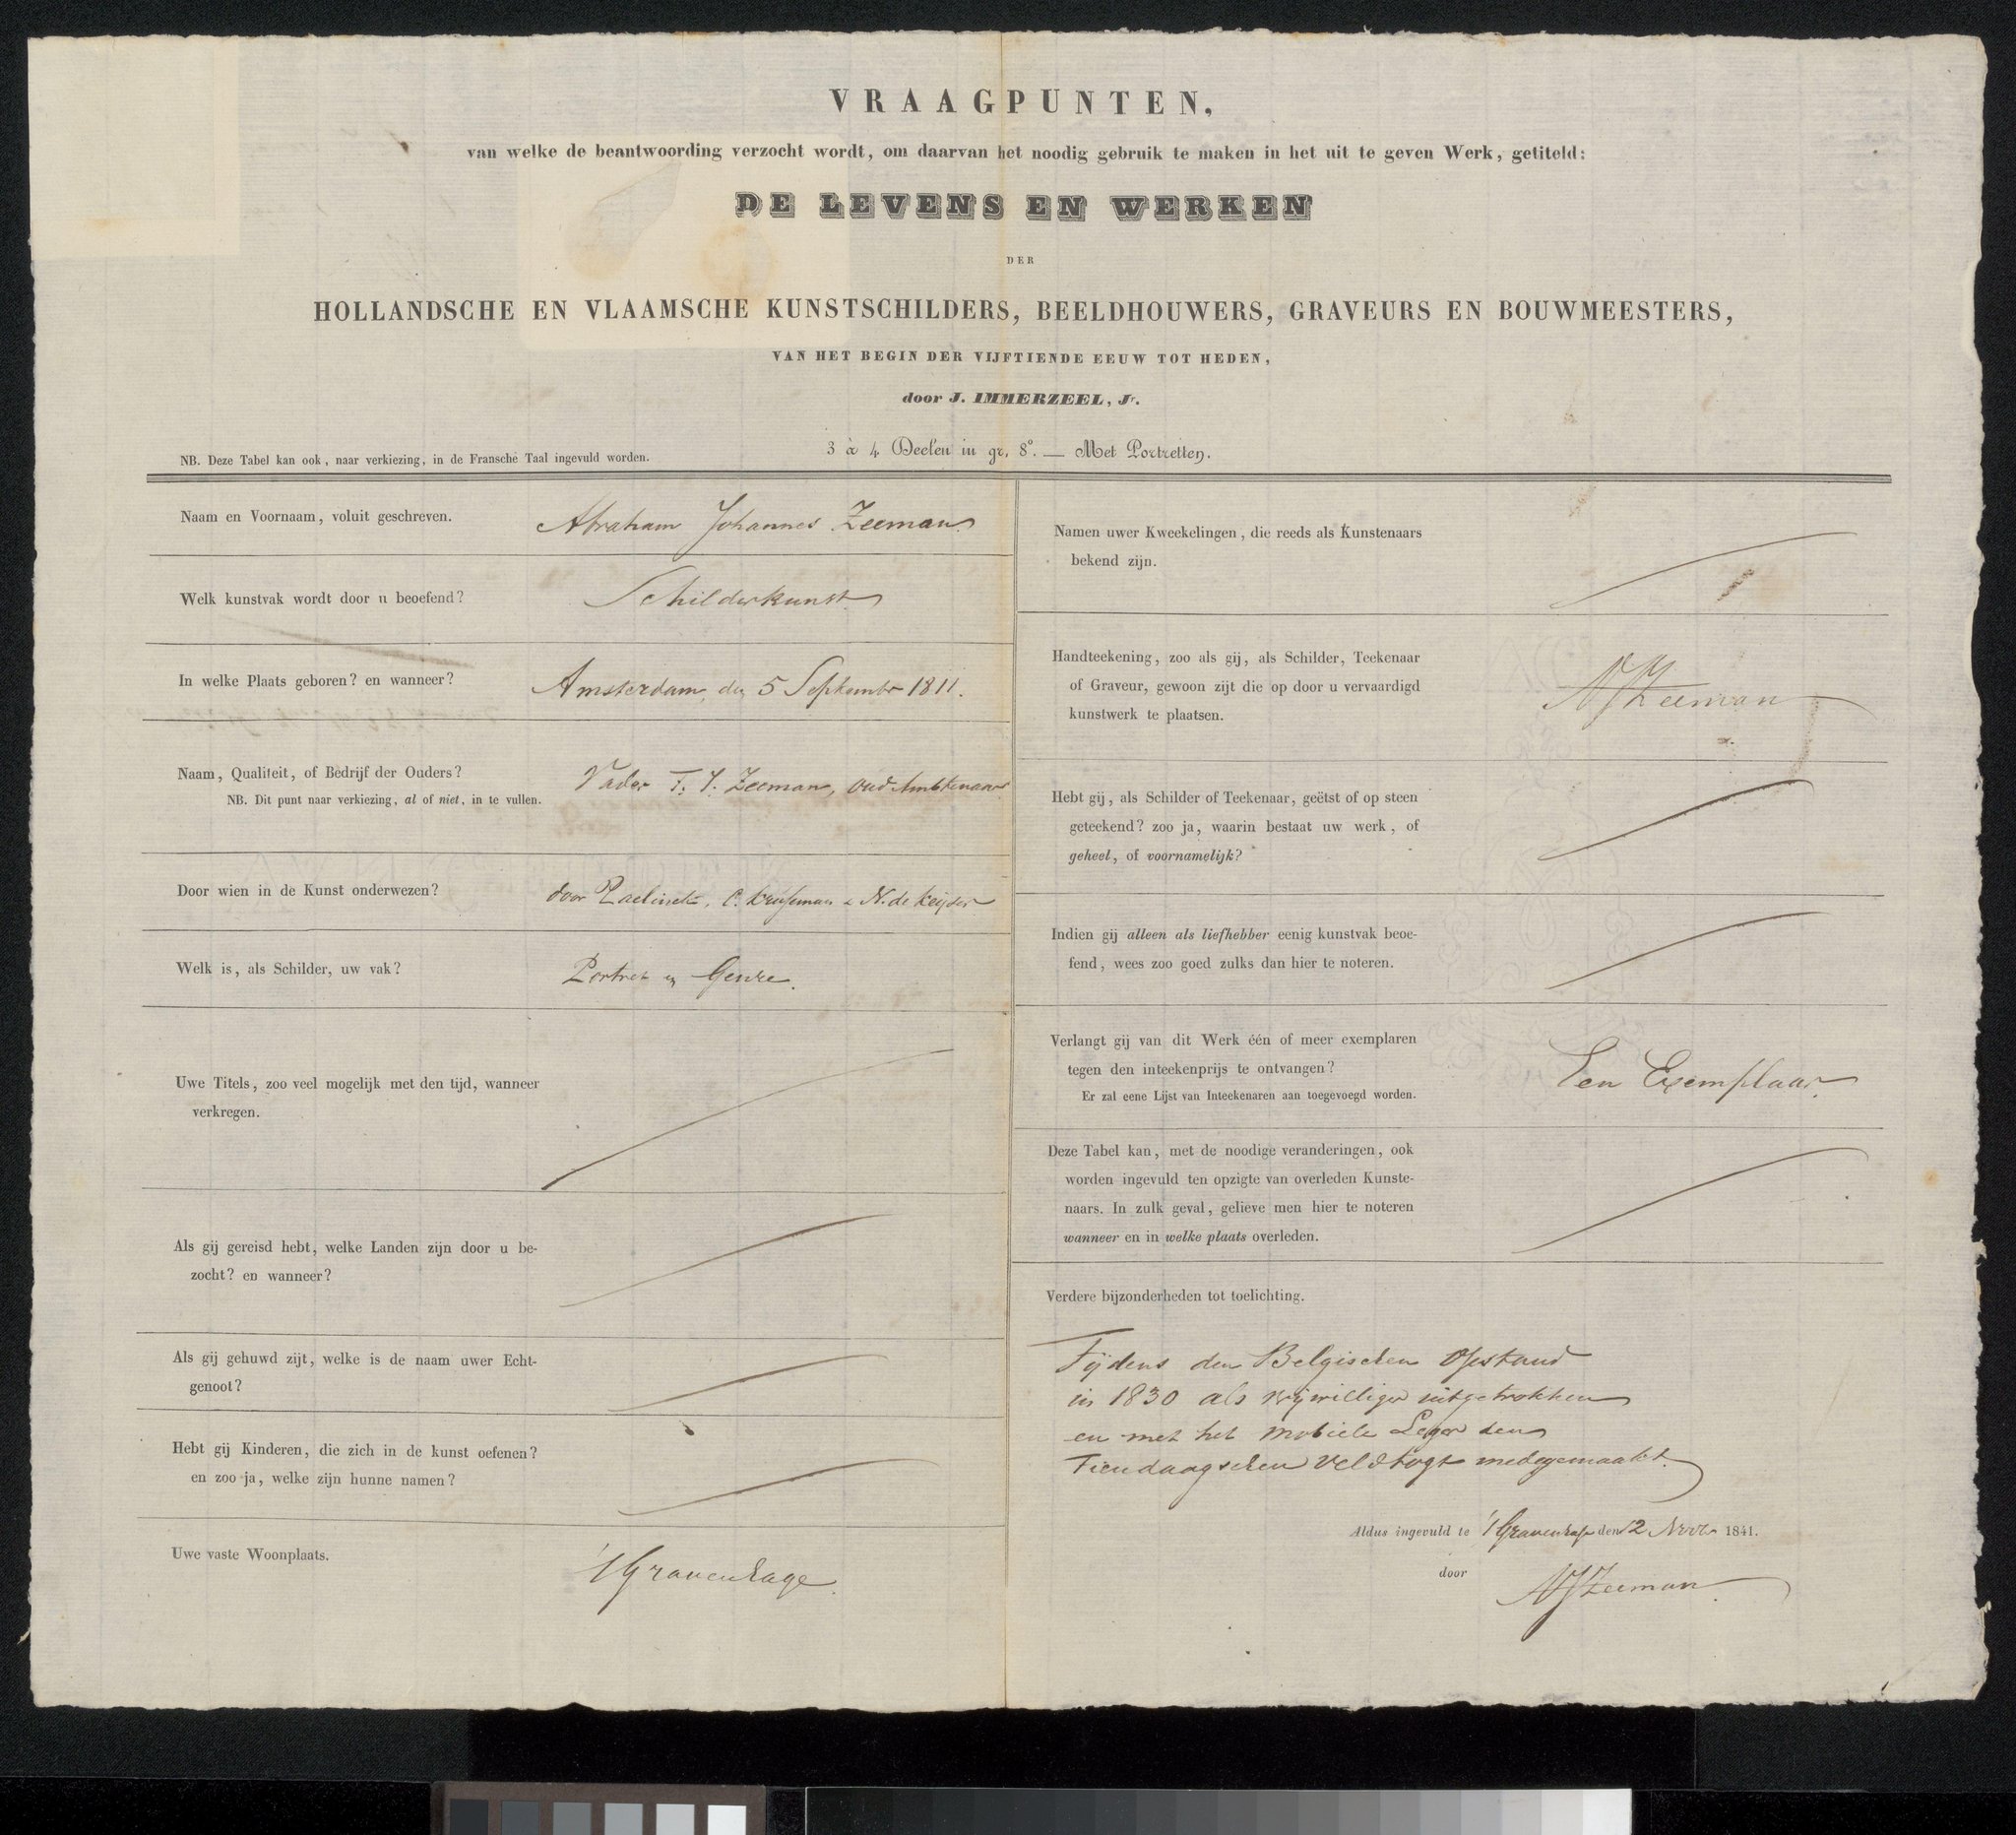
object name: manuscript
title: Enquêteformulier ingevuld door Abraham Johannes Zeeman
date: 1841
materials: ink, paper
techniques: pen, printing, writing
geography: the hague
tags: antwerp, painter, draughtsman, abraham johannes zeeman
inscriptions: inscription: ‘Vraagpunten,/ van welke de beantwoording verzocht wordt, om daarvan het noodig gebruik te maken in het uit te geven Werk, getiteld: De levens en werken/ der Hollandsche en Vlaamsche kunstschilders, beeldhouwers,/ graveurs en bouwmeesters, van het begin der vijftiende eeuw tot heden/ door J. Immerzeel, Jr.’, watermark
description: Opgenomen in: Immerzeel, J. Jr., De levens en werken der Hollandsche en Vlaamsche kunstschilders, beeldhouwers, graveurs en bouwmeesters, van het begin der vijftiende eeuw tot heden, Amsterdam: J.C. van Kesteren, 1842-1843.